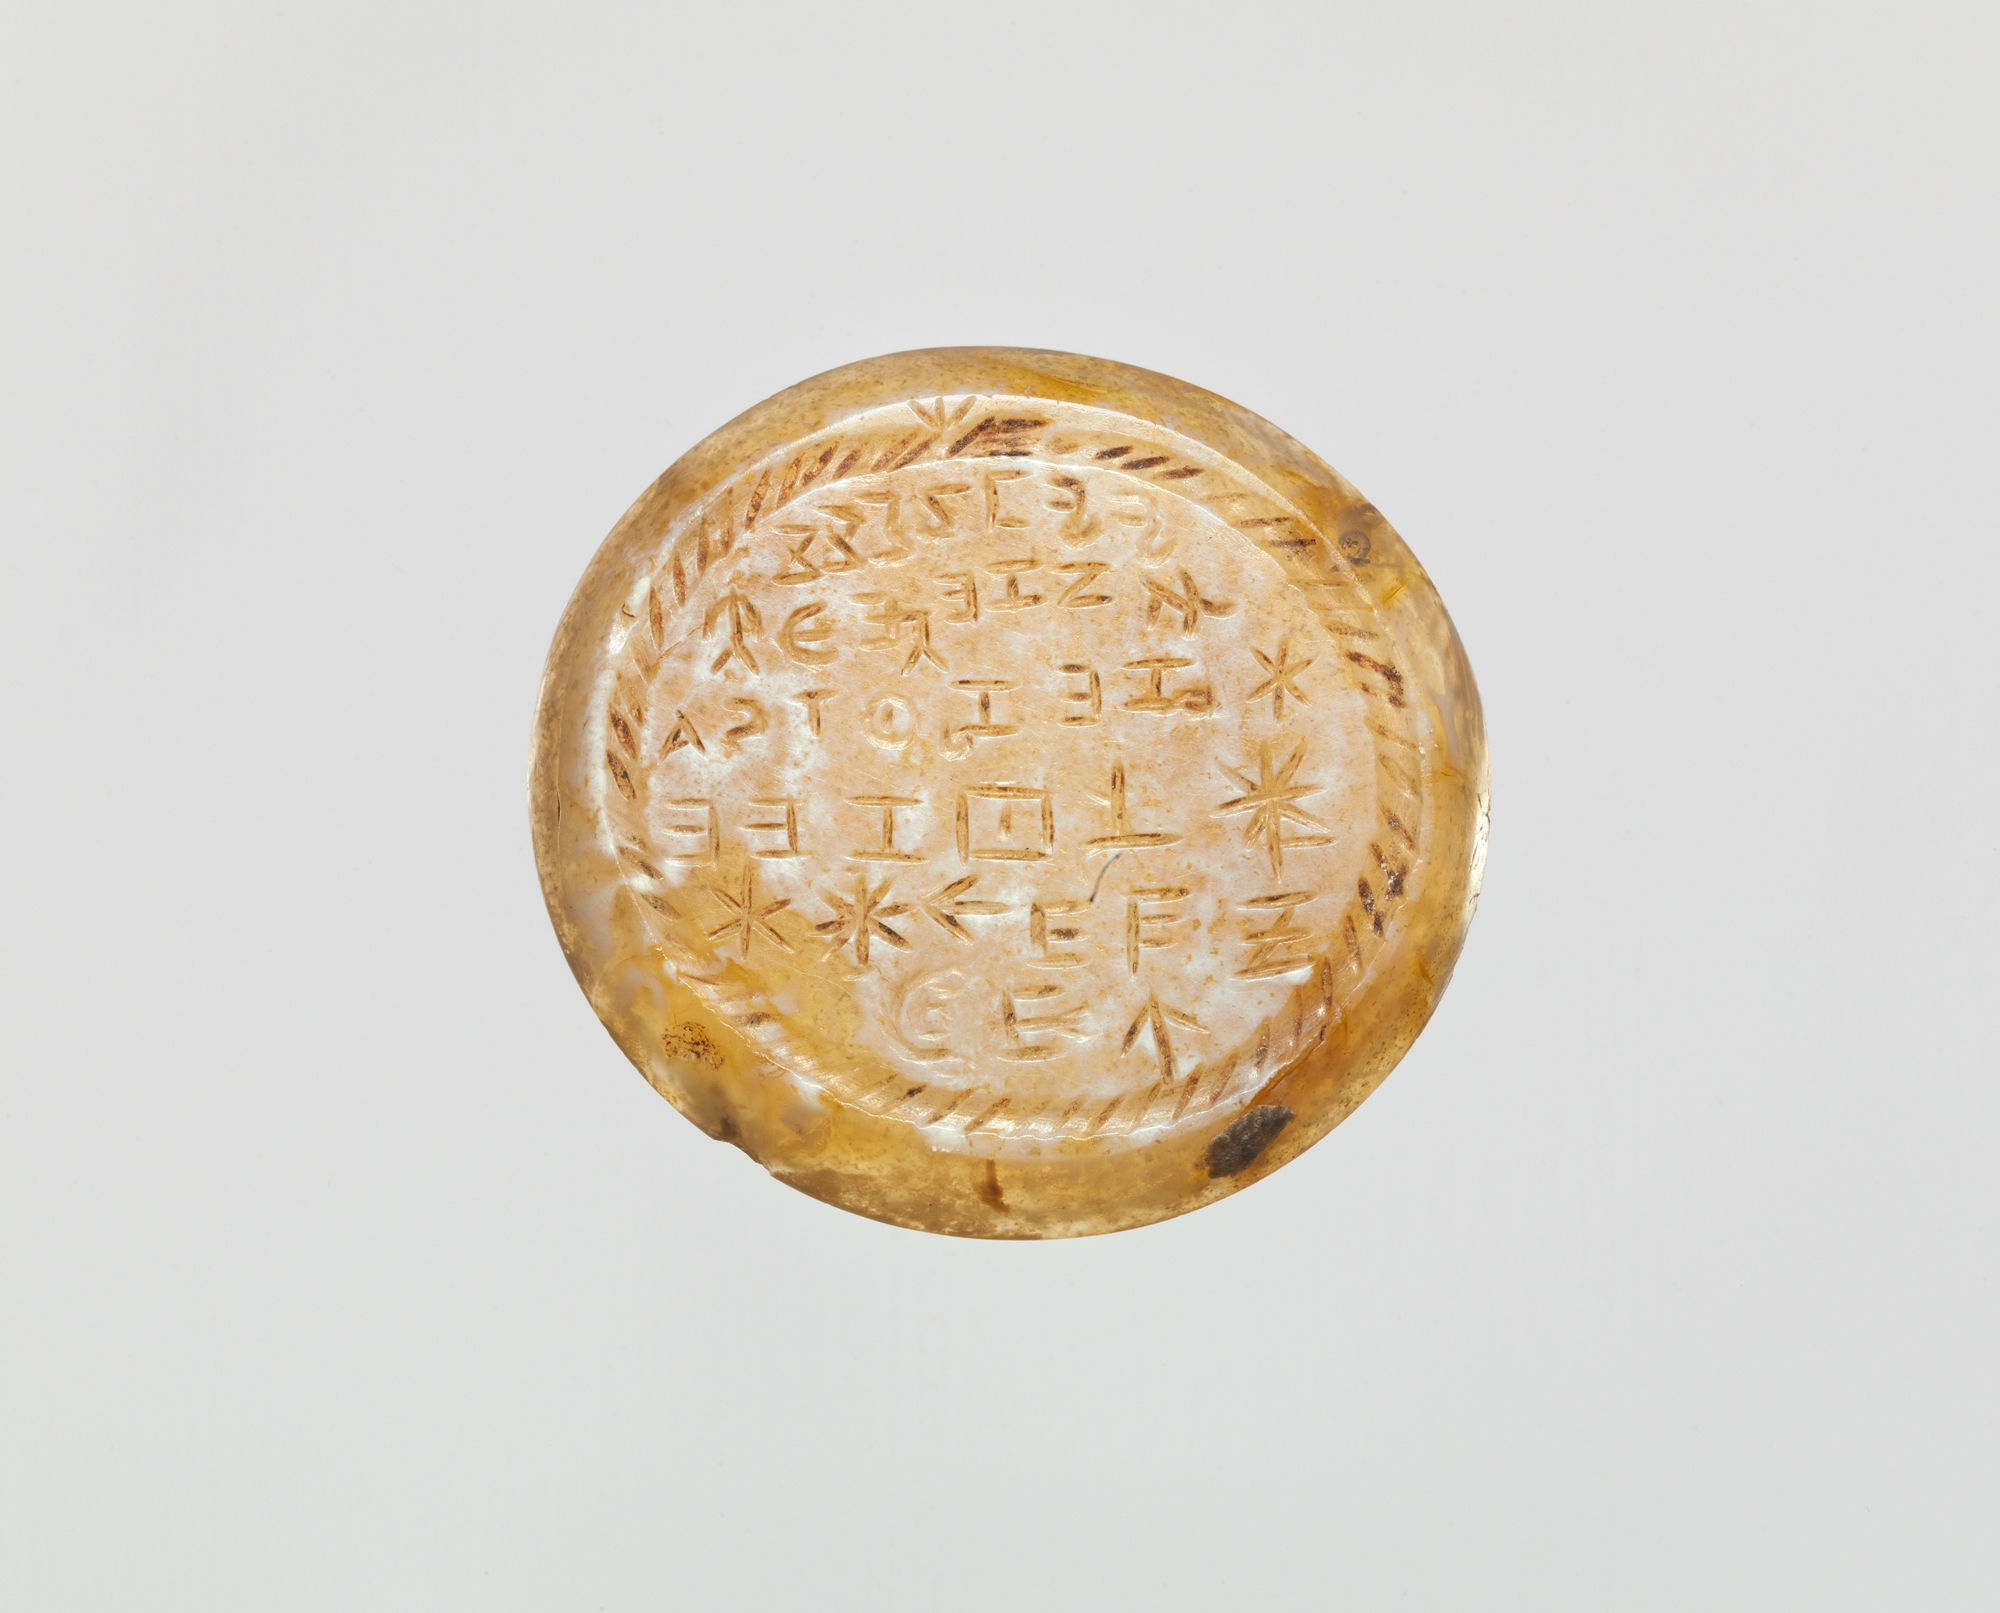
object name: intaglio, magical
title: Onyx intaglio: Incantation in Greek letters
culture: roman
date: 101-300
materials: onyx